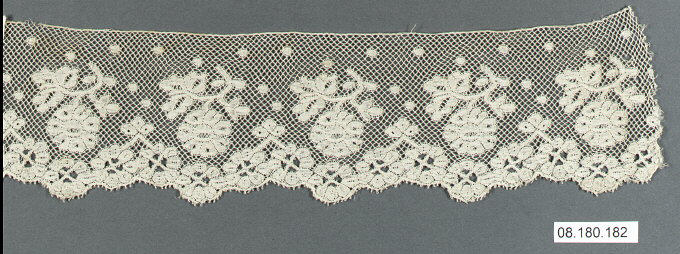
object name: fragment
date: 1801-1900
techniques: lace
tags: flowers,leaves